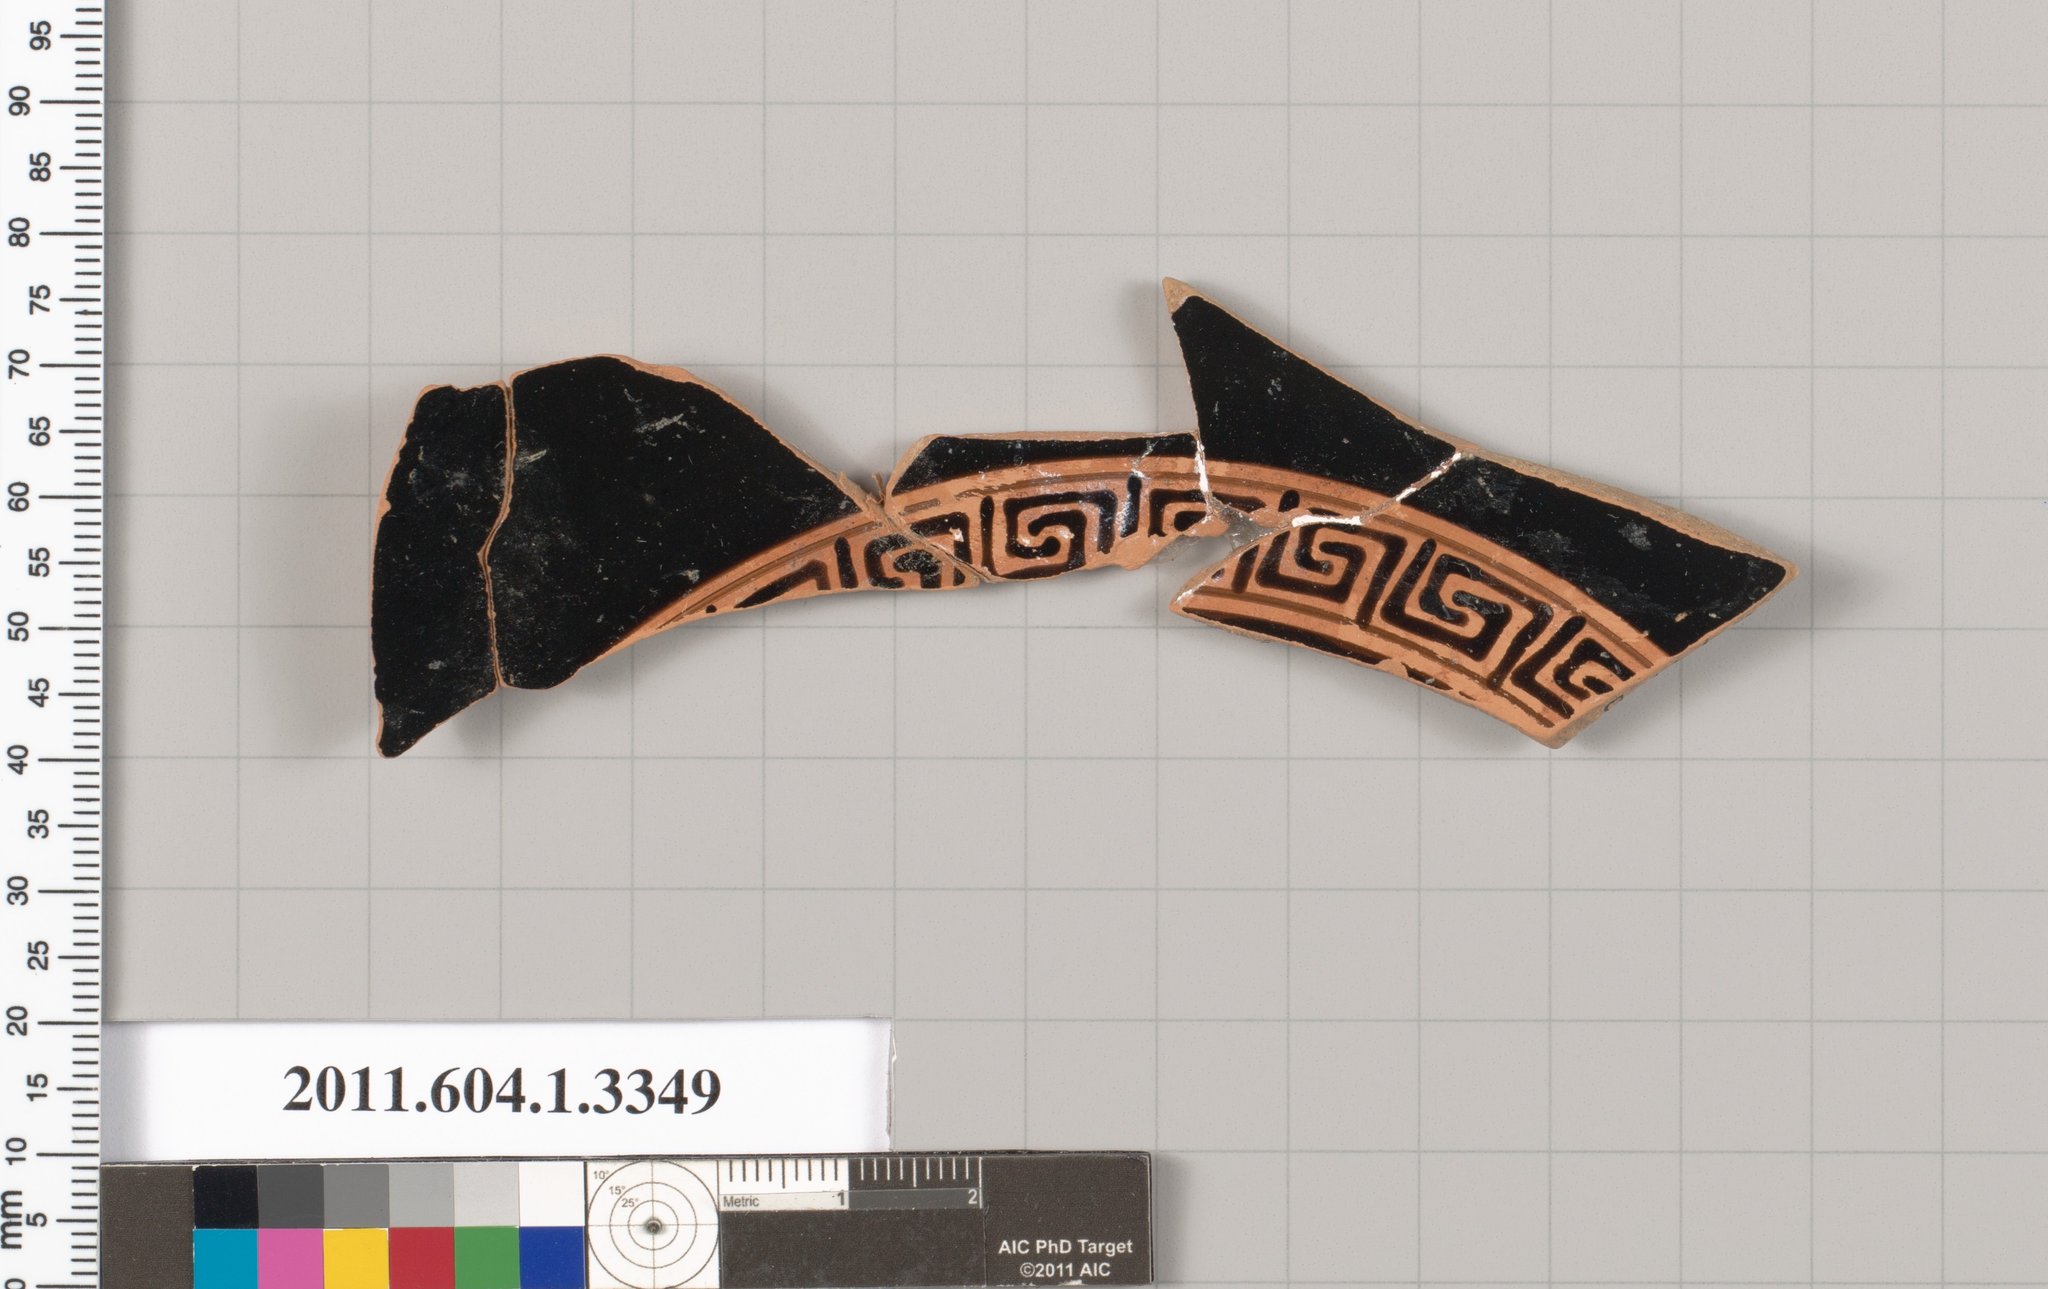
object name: kylix fragment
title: Terracotta fragment of a kylix (drinking cup)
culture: greek, attic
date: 500-470 BCE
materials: terracotta